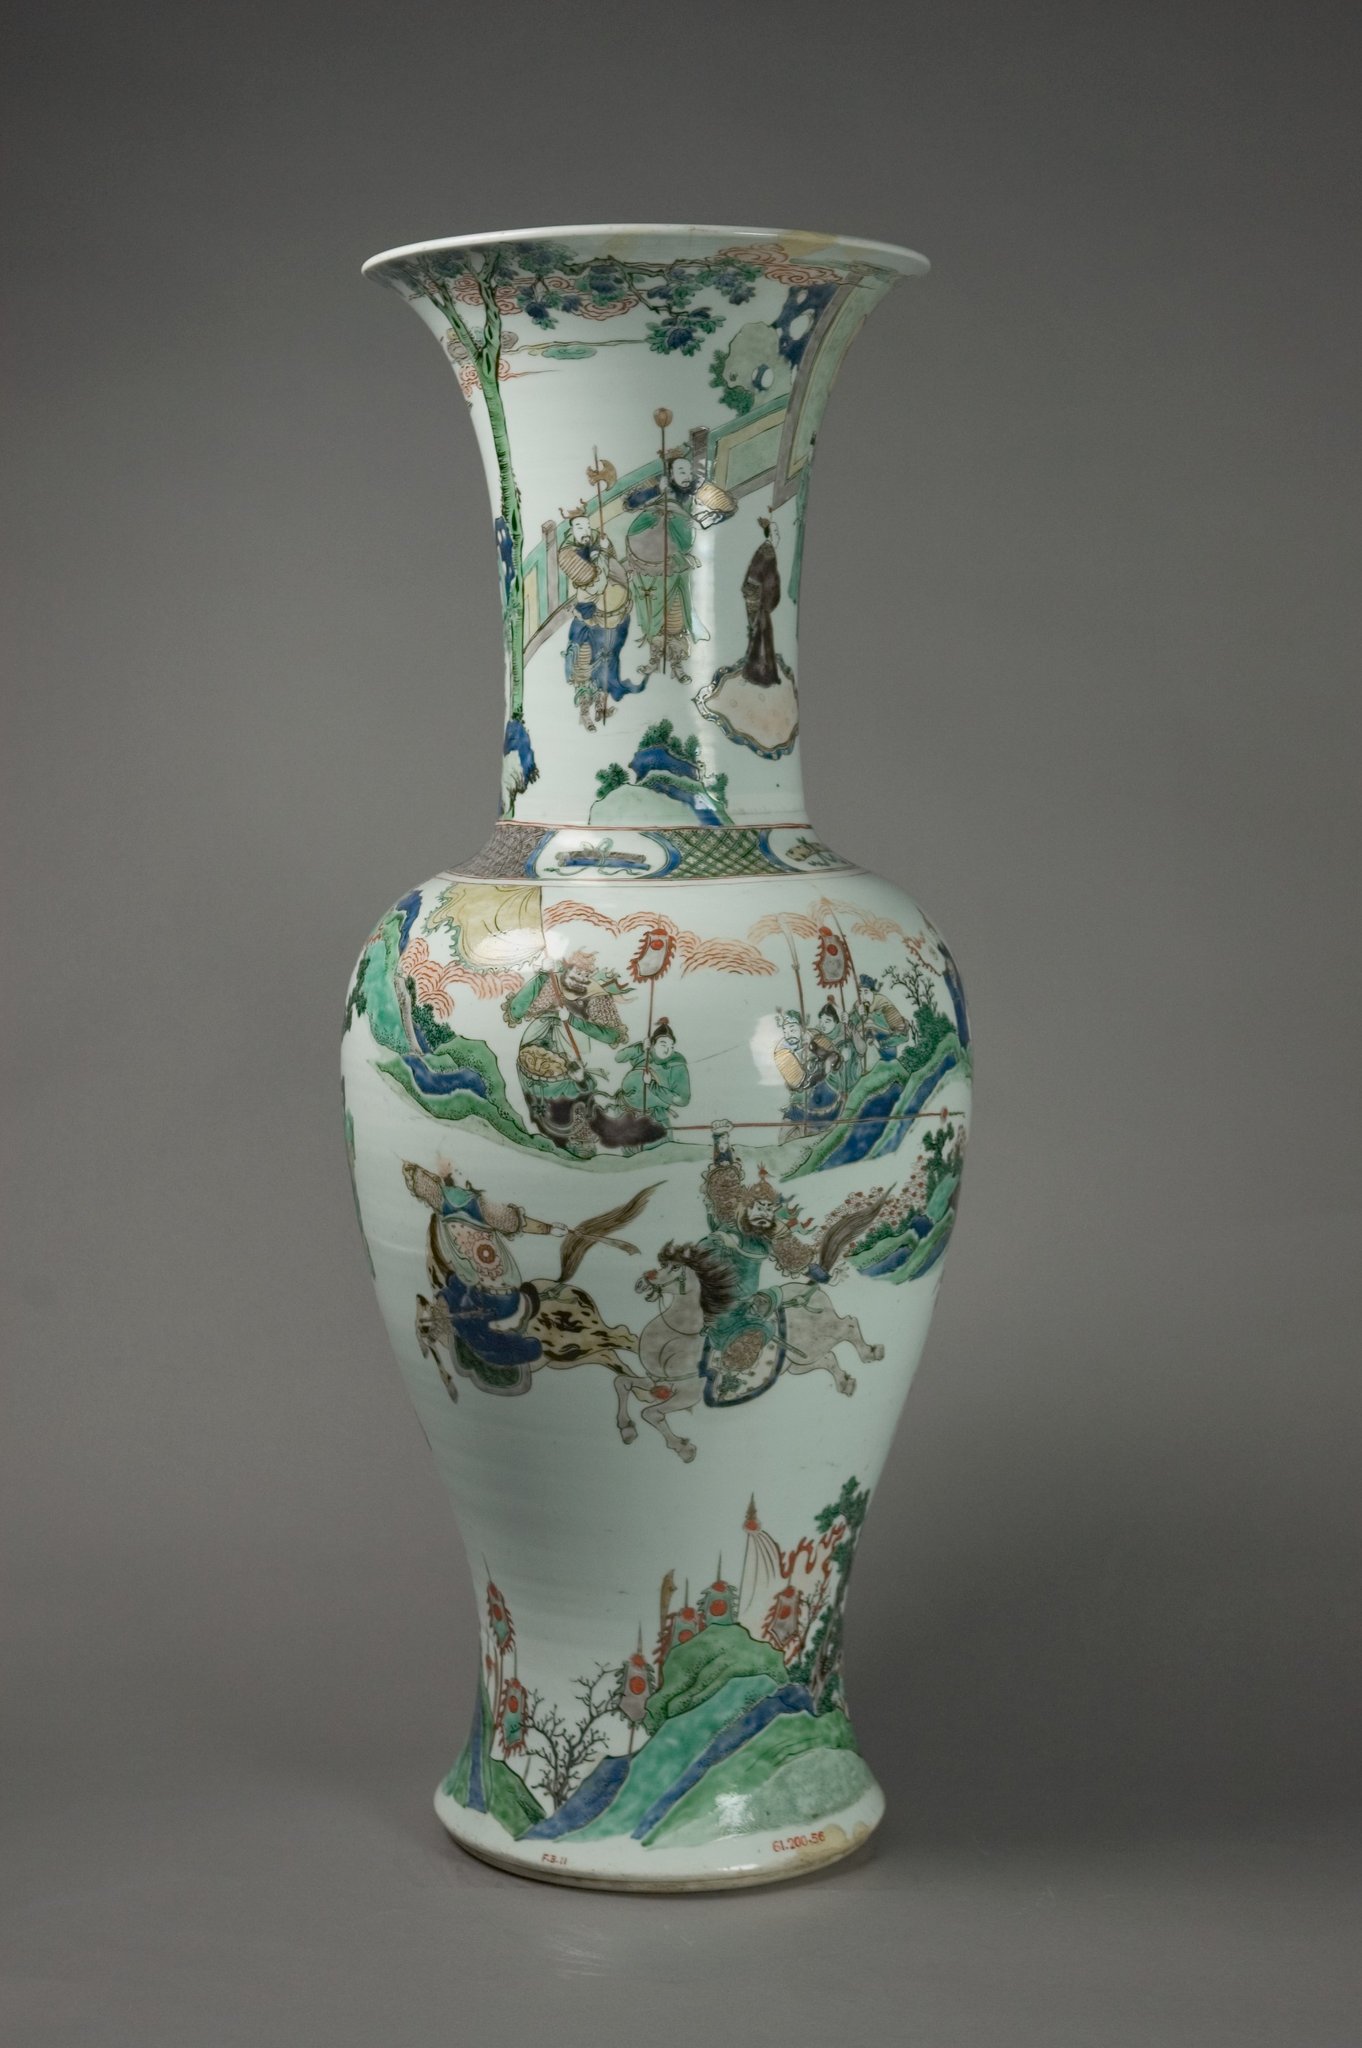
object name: vase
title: Vase with historical warriors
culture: chinese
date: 1644-1911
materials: enamel, glaze, porcelain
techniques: painting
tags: weapons,men,horses